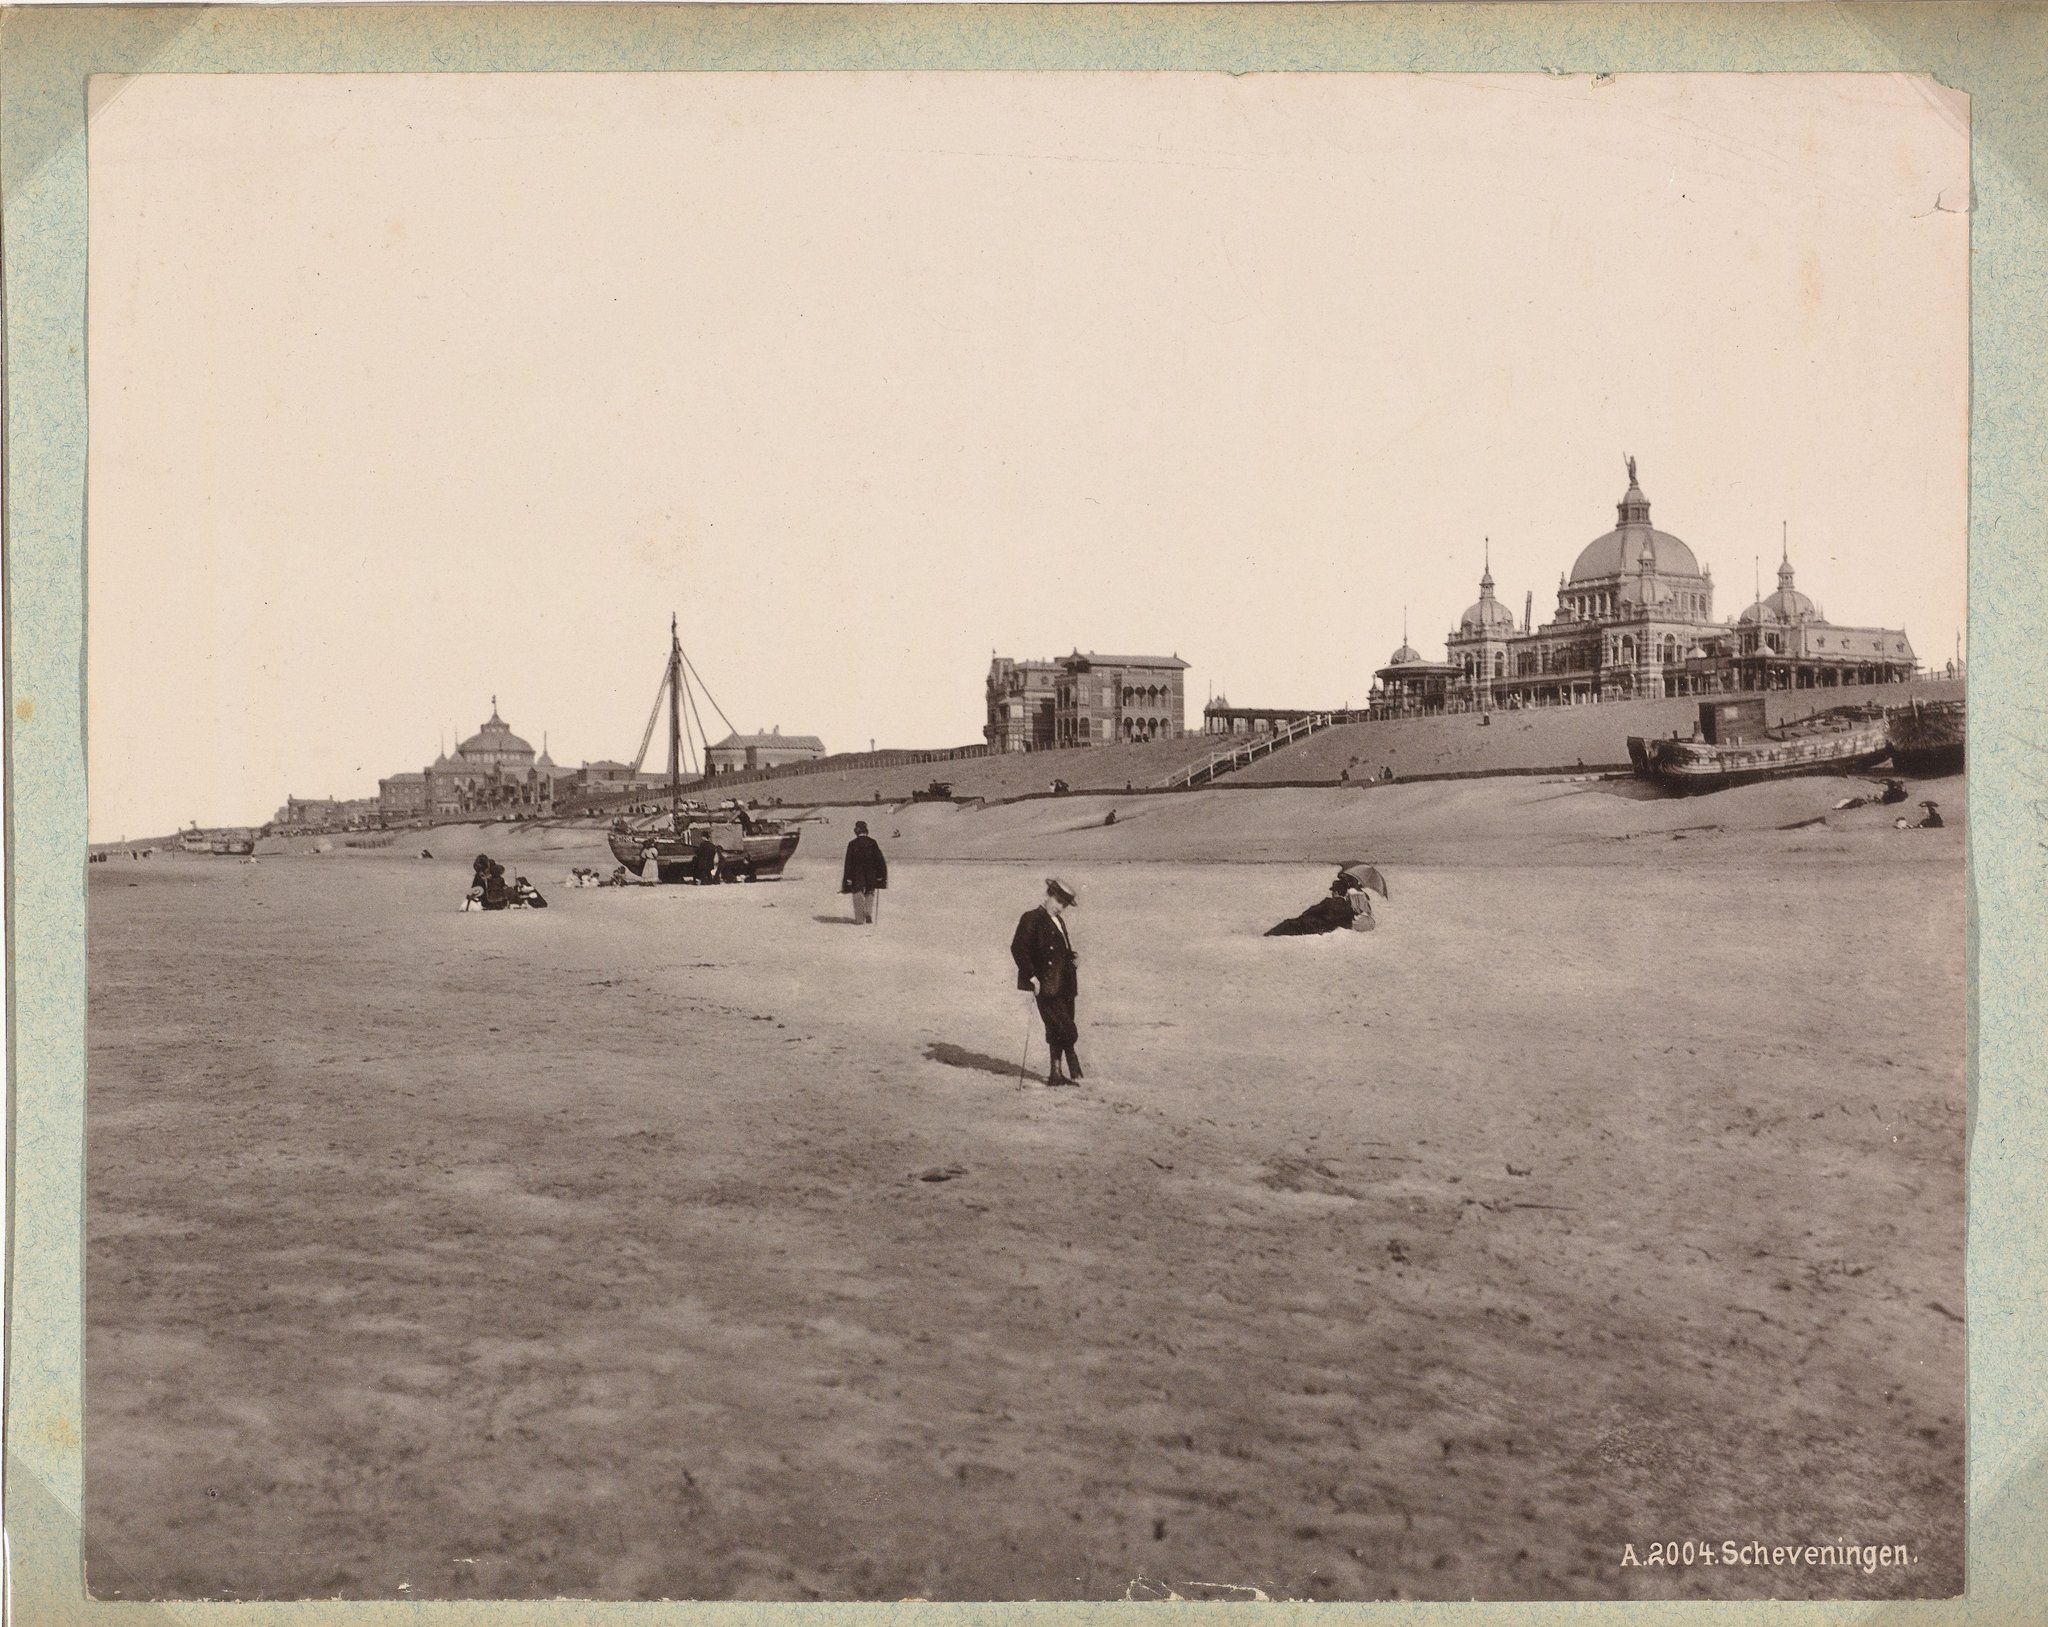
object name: photograph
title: A. 2004 Scheveningen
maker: Anonymous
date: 1885-1930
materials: paper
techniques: photograph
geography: netherlands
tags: watering-place, spa, beach